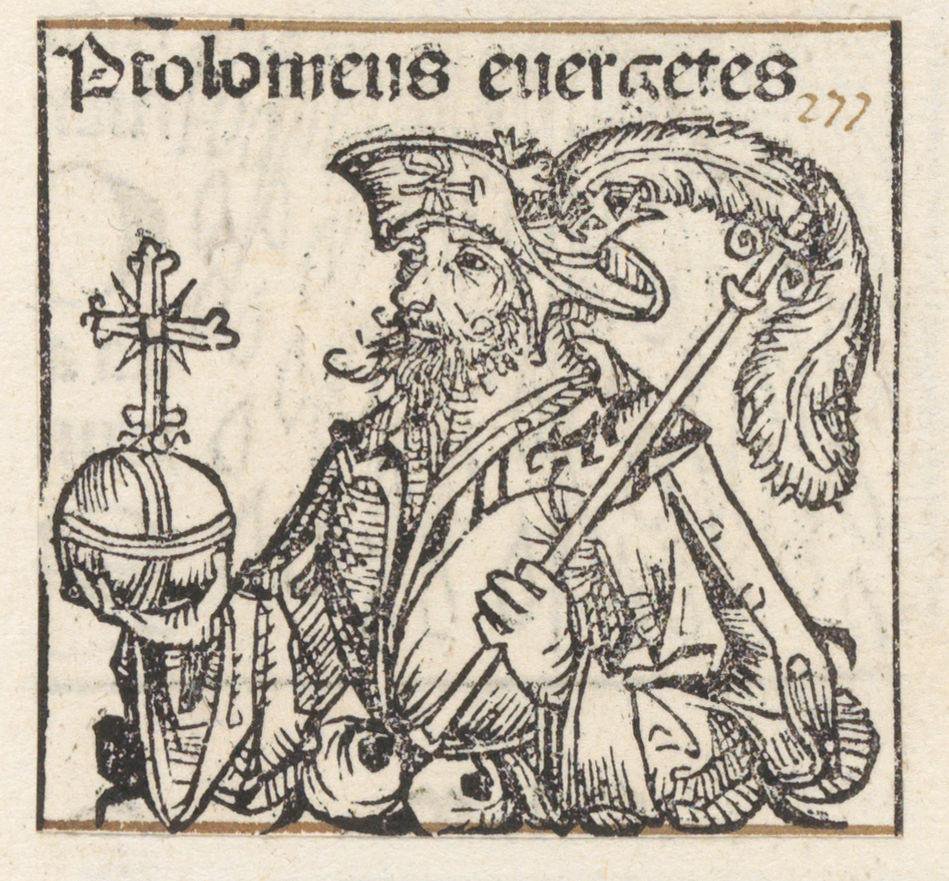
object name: book illustration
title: Liber Chronicarum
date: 1493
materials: paper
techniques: letterpress printing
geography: nuremberg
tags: king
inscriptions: inscription: ‘277’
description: Een bloemkelk waarin een koning met pluimhoed, rijksappel en scepter, naar links gericht. De voorstelling is een onderdeel van de opeenvolging Egyptische farao's in de Liber Chronicarum. De tekst identificeert hem als farao Ptolemaeus VIII Euergetes II (bijnaam Physcon). De prent maakt deel uit van een album.